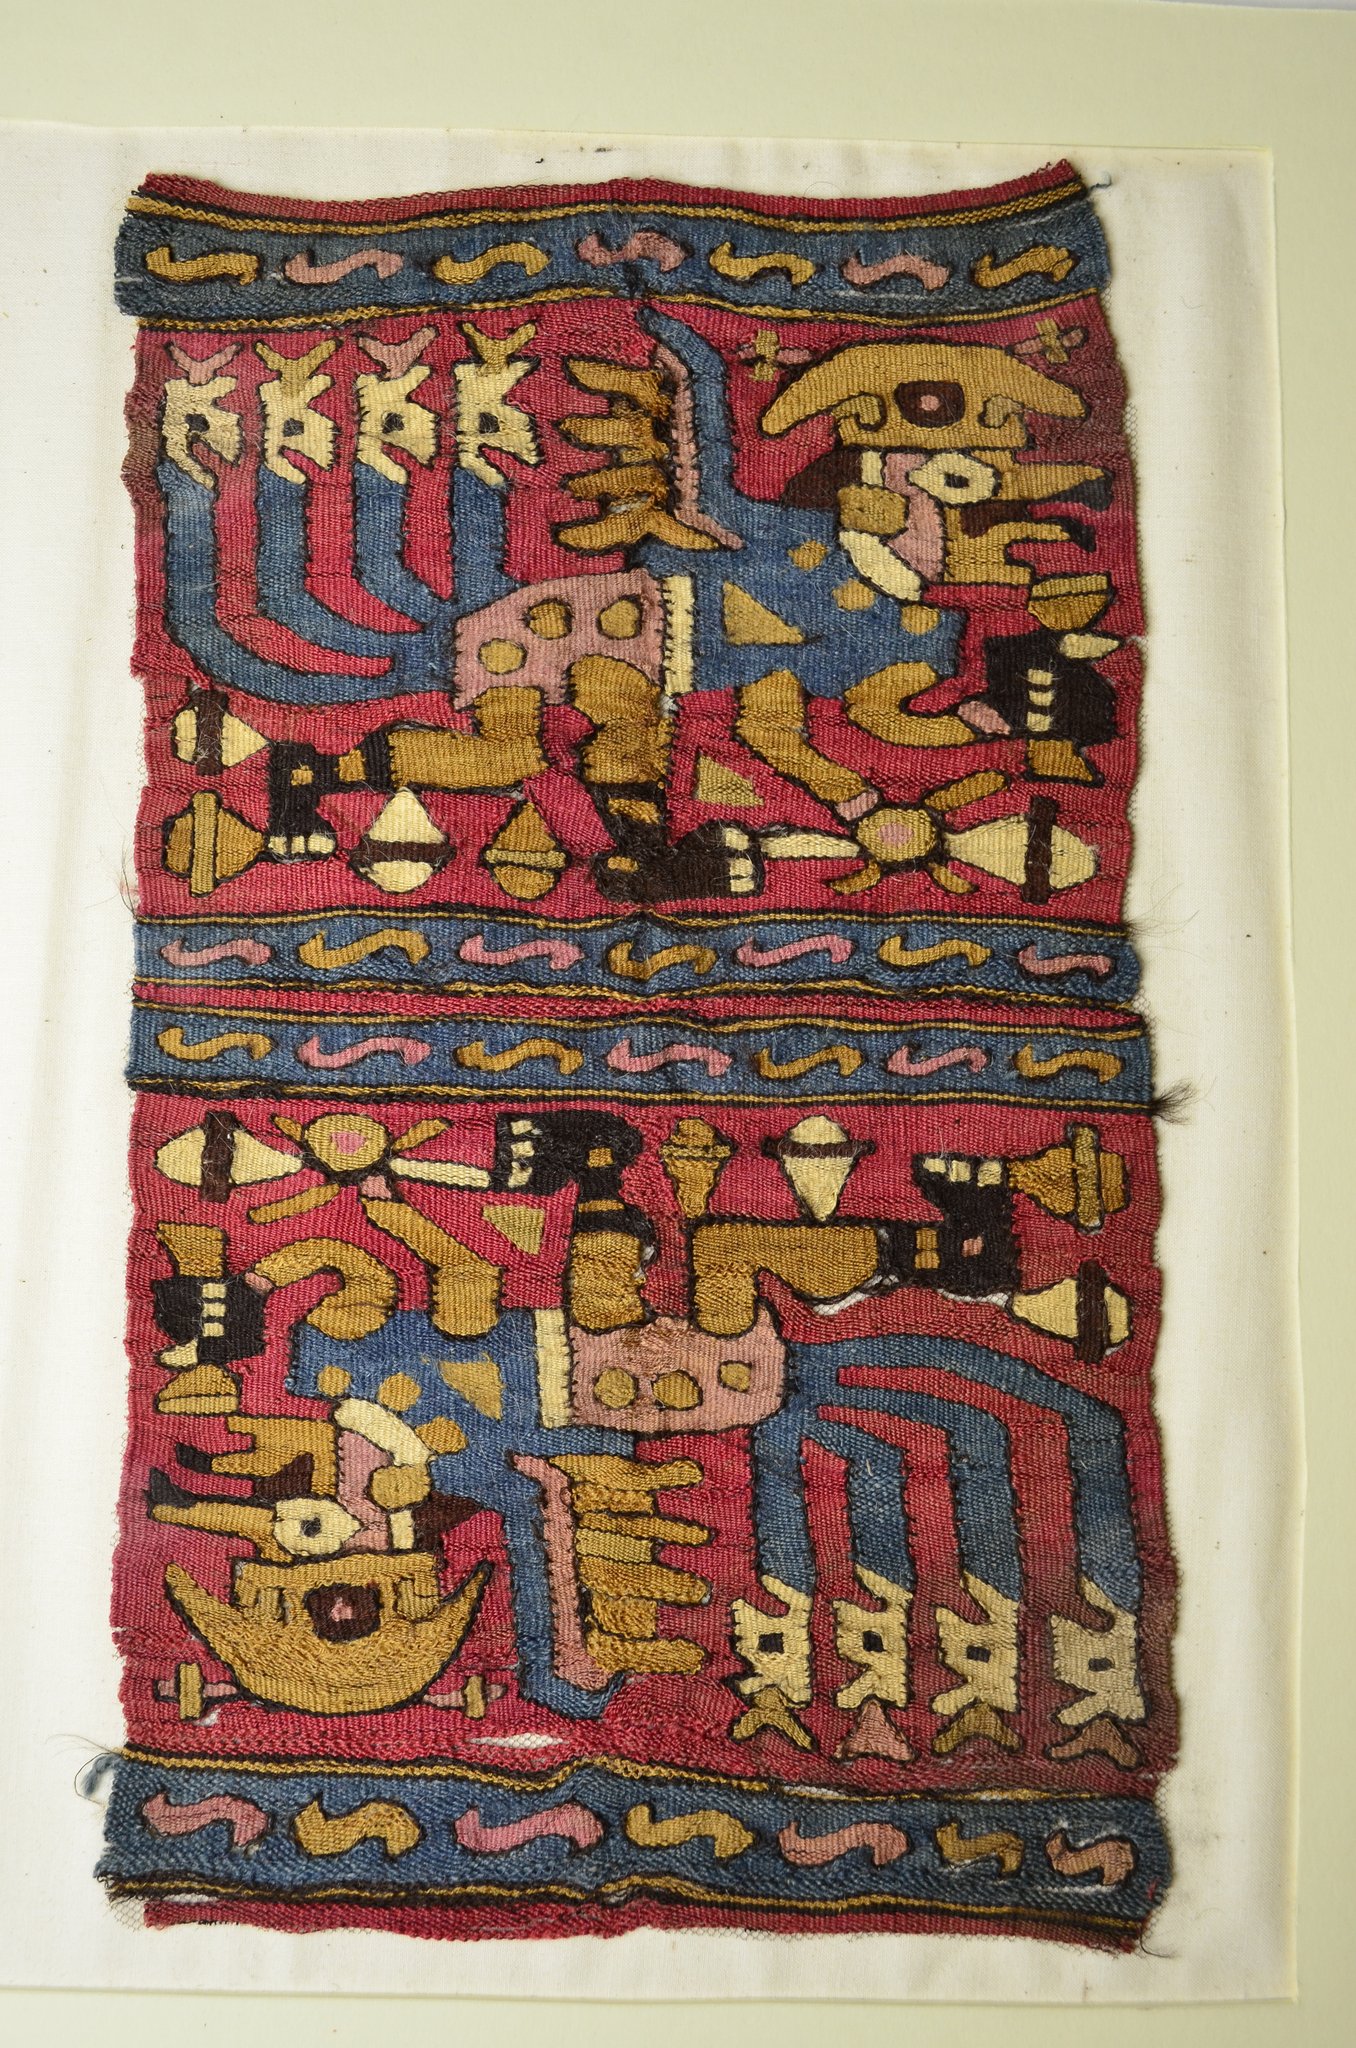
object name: bag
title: Coca bag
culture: moche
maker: moche artist(s)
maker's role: artist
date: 400-700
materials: animal fiber, cotton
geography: peru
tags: mythical creatures